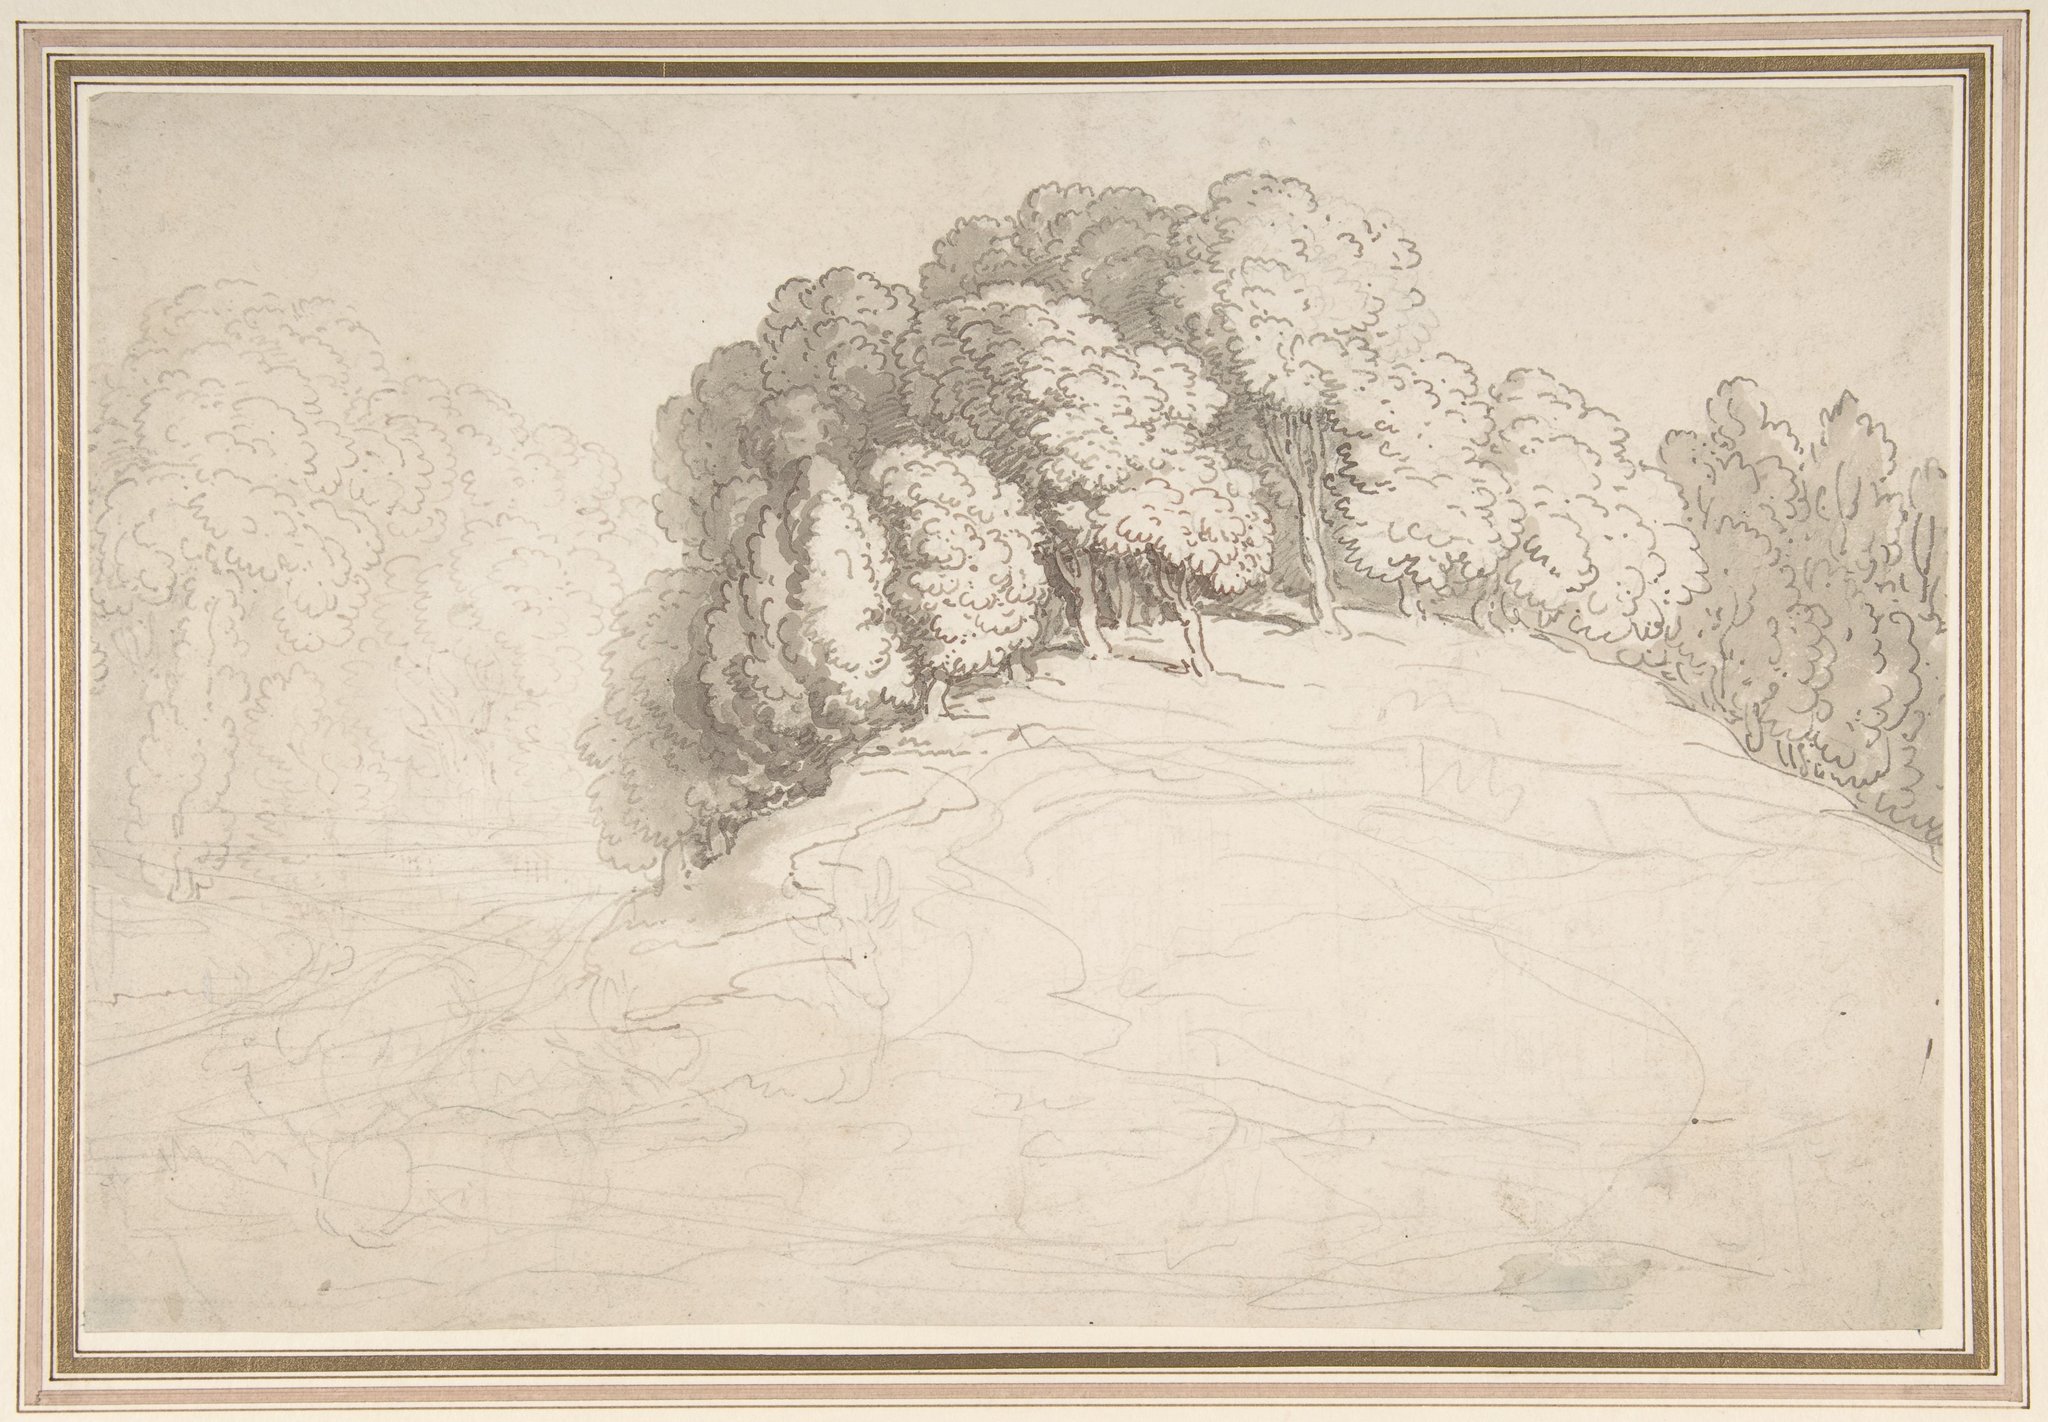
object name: drawing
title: Wooded hillside with deer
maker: thomas rowlandson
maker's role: artist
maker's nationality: british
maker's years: 1757-1827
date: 1780-1827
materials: graphite, ink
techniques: brush, pen, wash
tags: deer,hills,trees